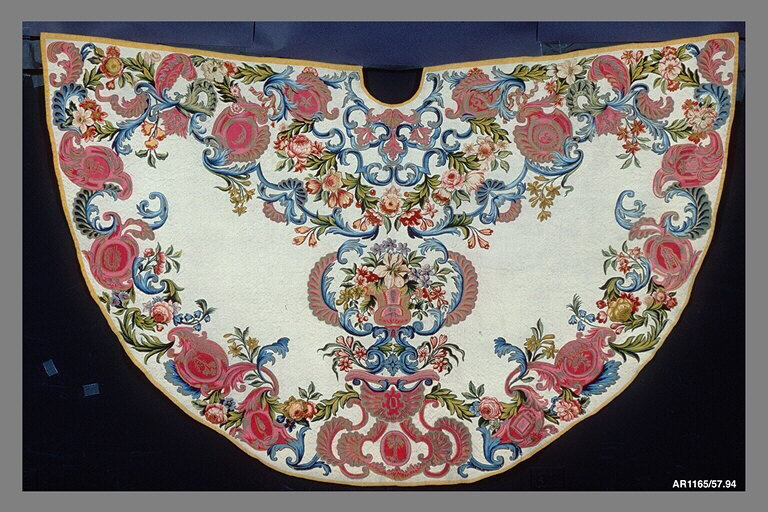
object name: mantle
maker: franciszek glaise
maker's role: maker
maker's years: 1743-1758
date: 1755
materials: silk, silver gilt, thread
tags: flowers